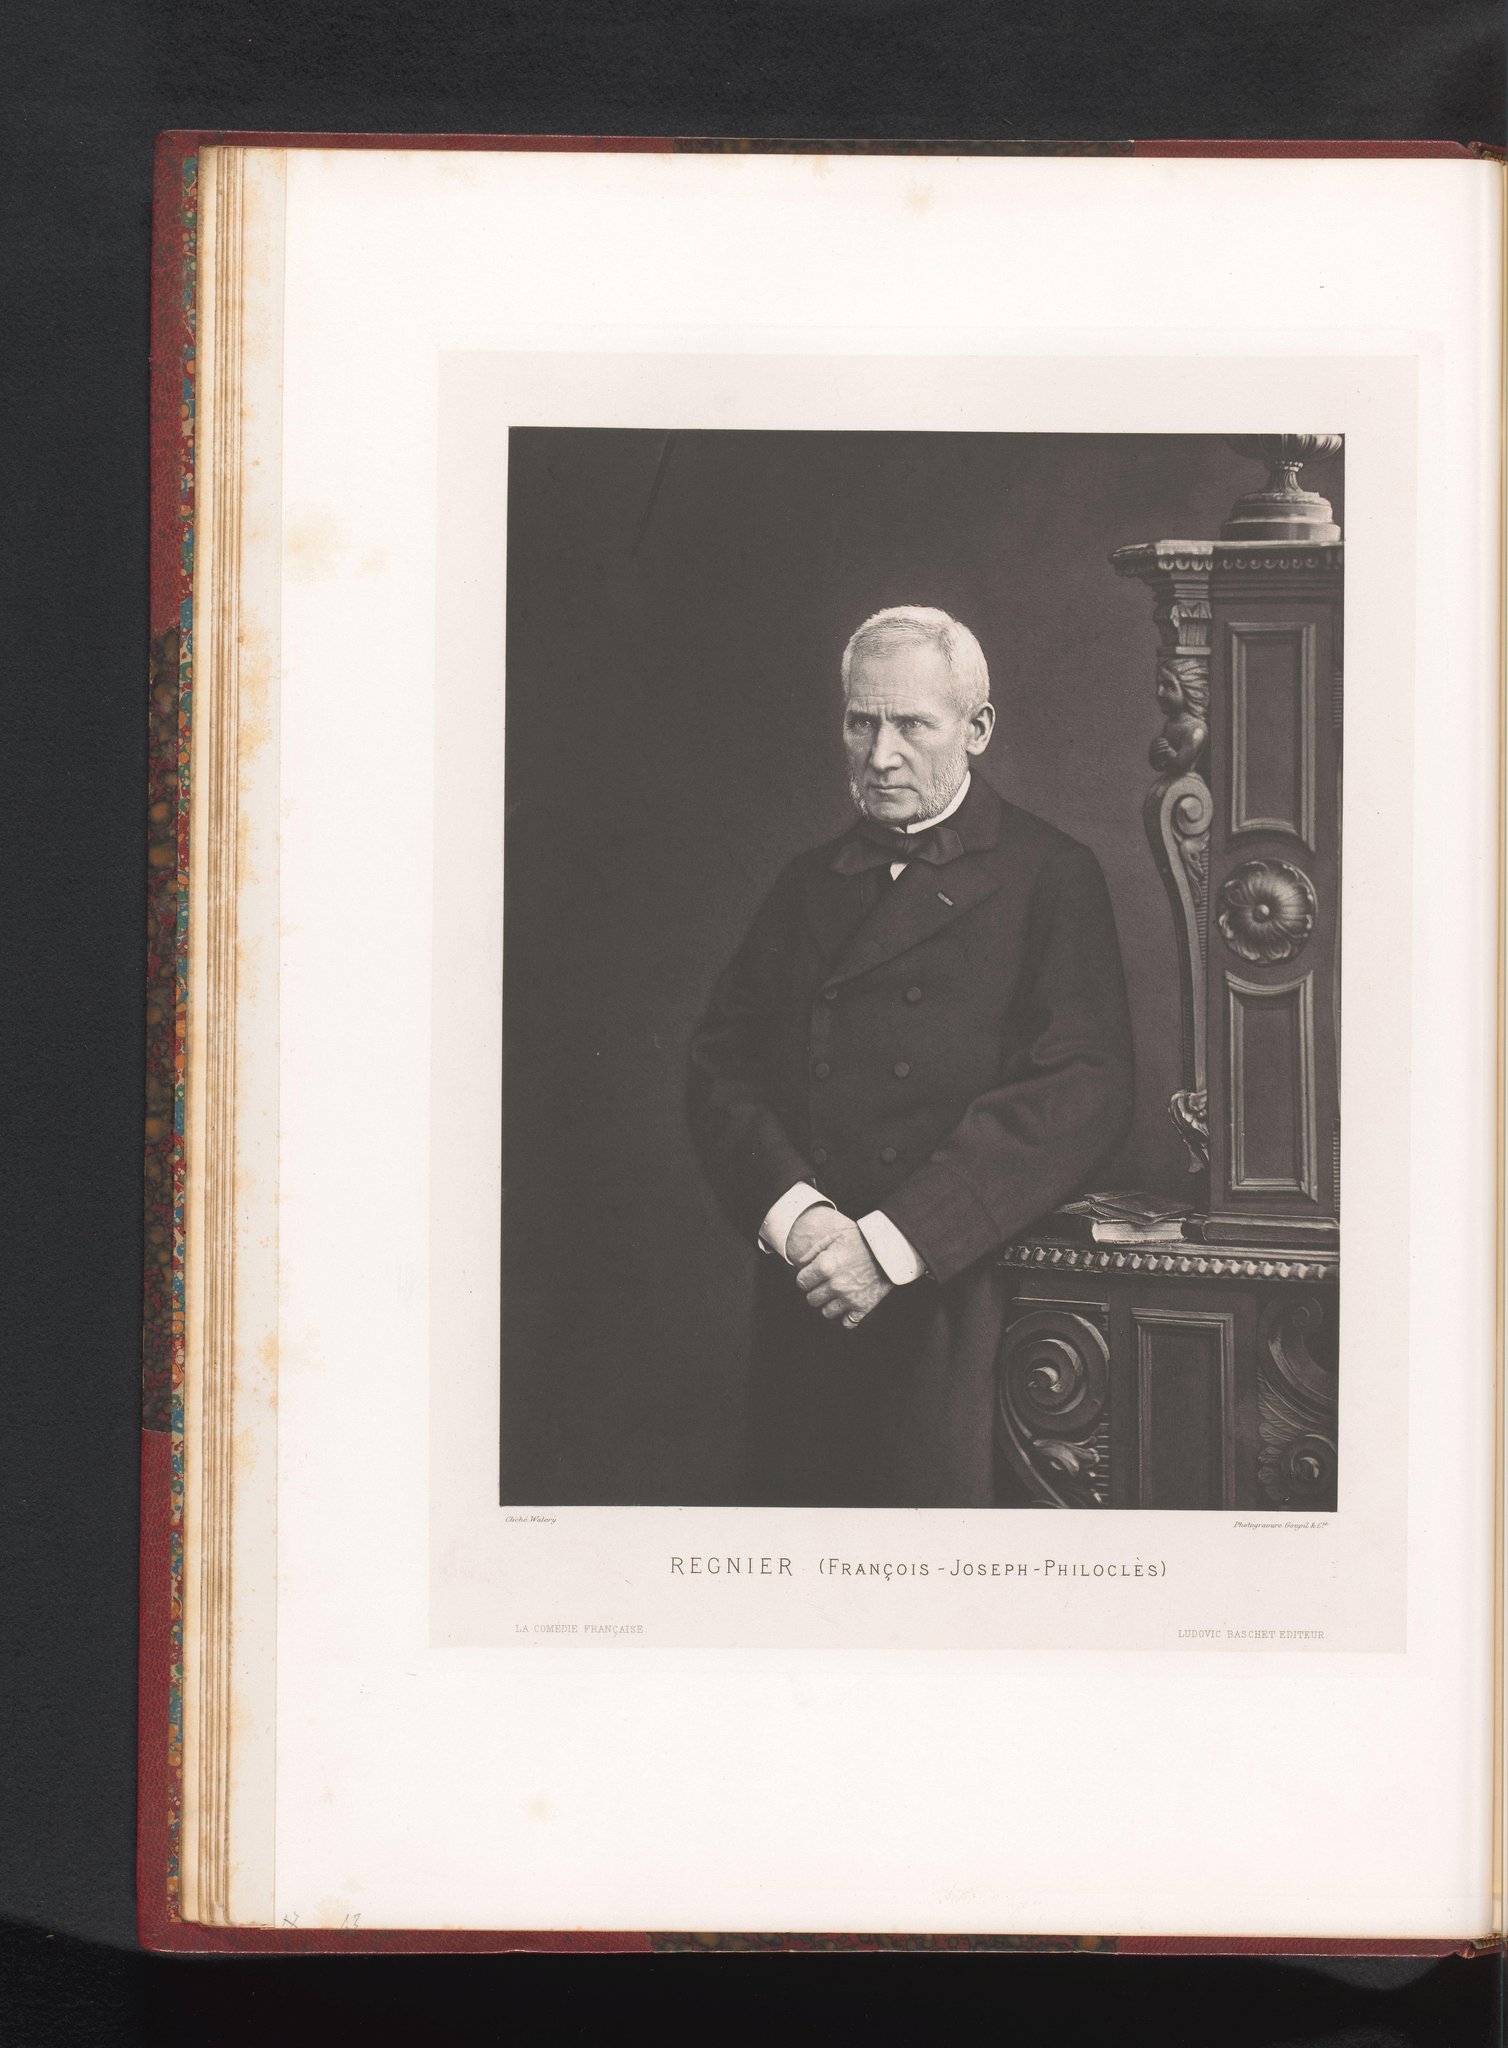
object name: page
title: Portret van François Joseph Philoclès Regnier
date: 1875-1880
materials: paper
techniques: photoaquatint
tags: historical persons, portrait of actor, actress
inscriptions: inscription: ‘LA COMÉDIE FRANÇAISE’, number: ‘13’